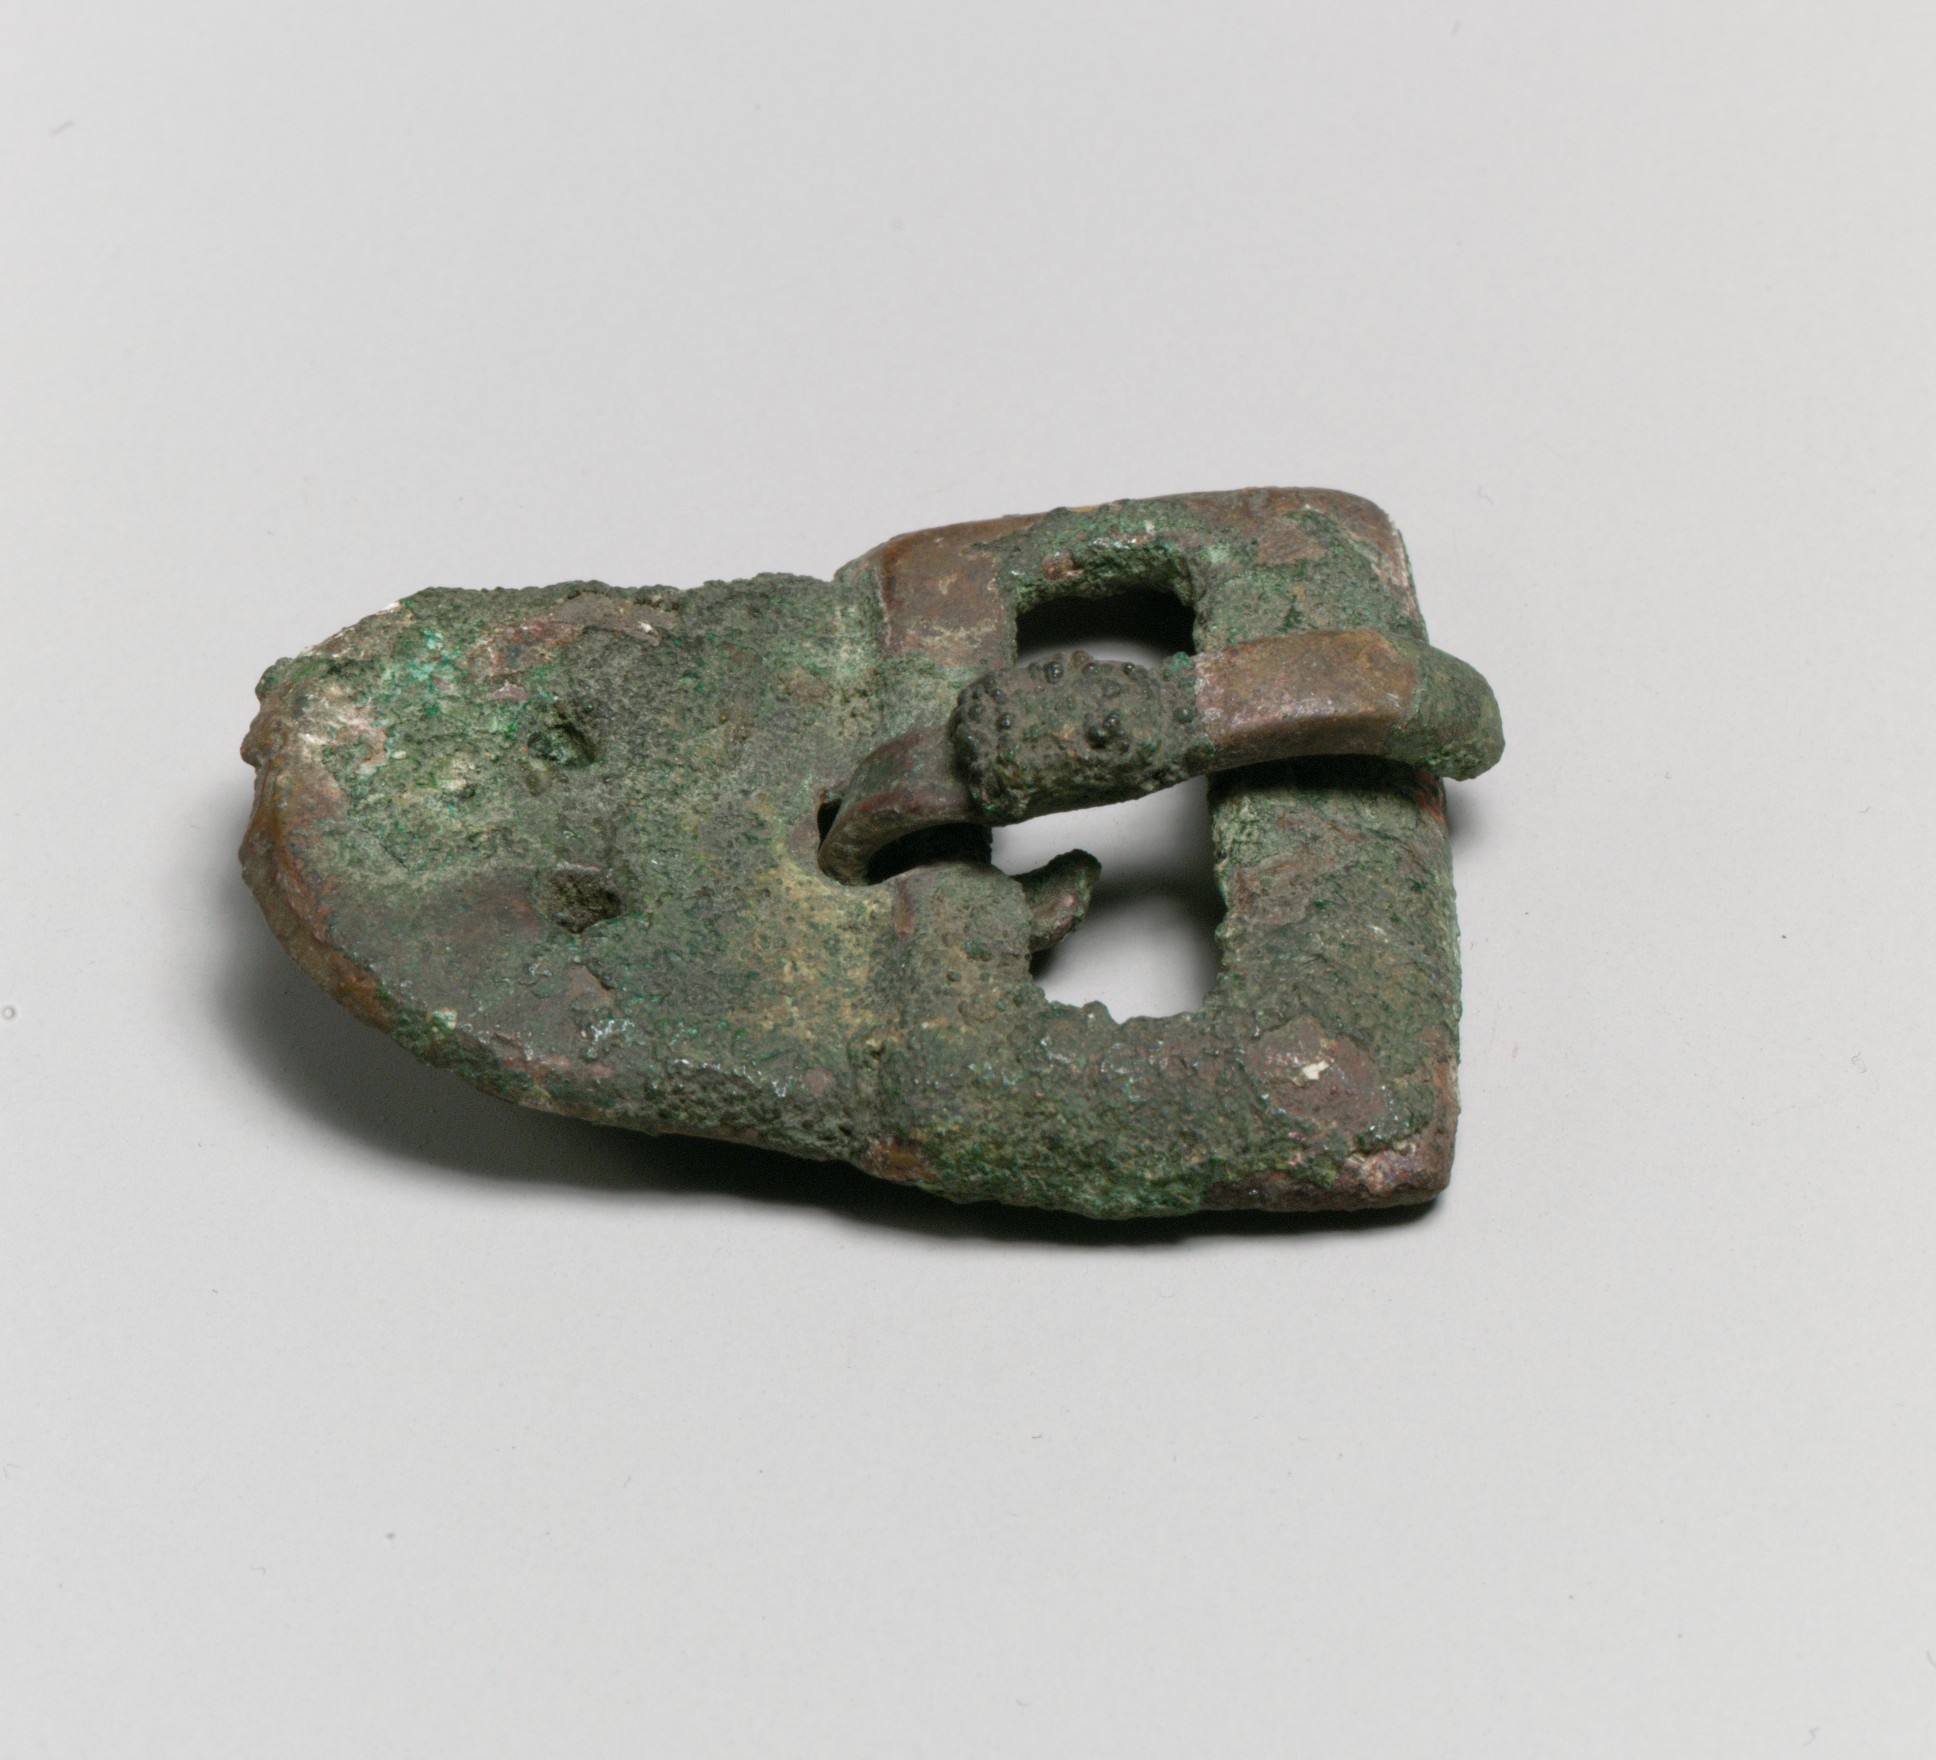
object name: buckle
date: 7000 BCE-330 CE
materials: bronze